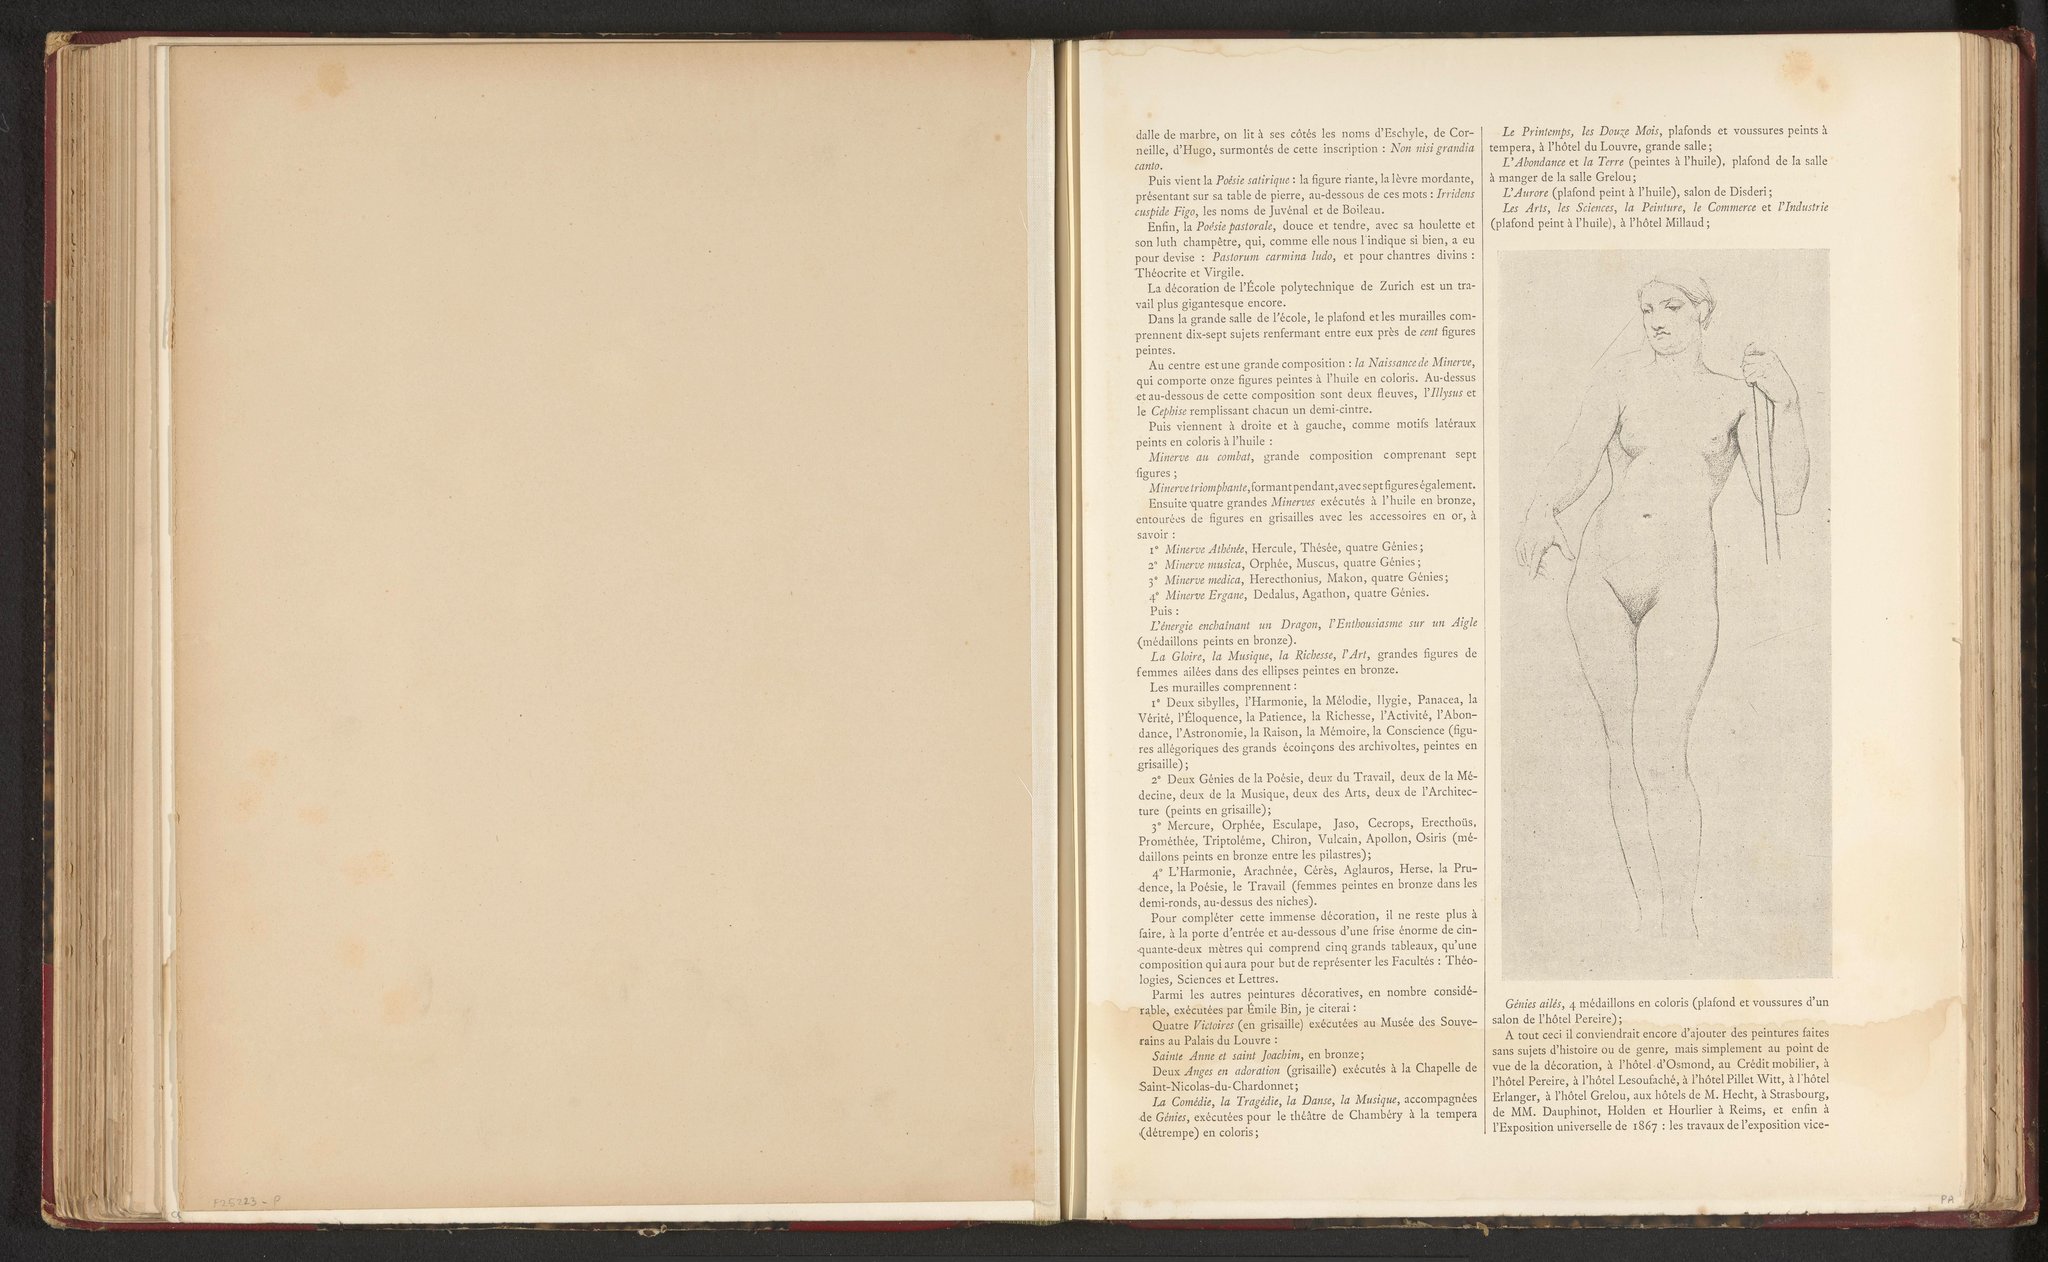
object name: reproduction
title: Fotoreproductie van een tekening door vermoedelijk Émile Bin, voorstellend een naakte vrouw met een stok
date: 1876-1879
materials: paper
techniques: autotype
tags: drawing, sketch, the (nude) human figure; 'corpo humano' (ripa) - aa - female human figure